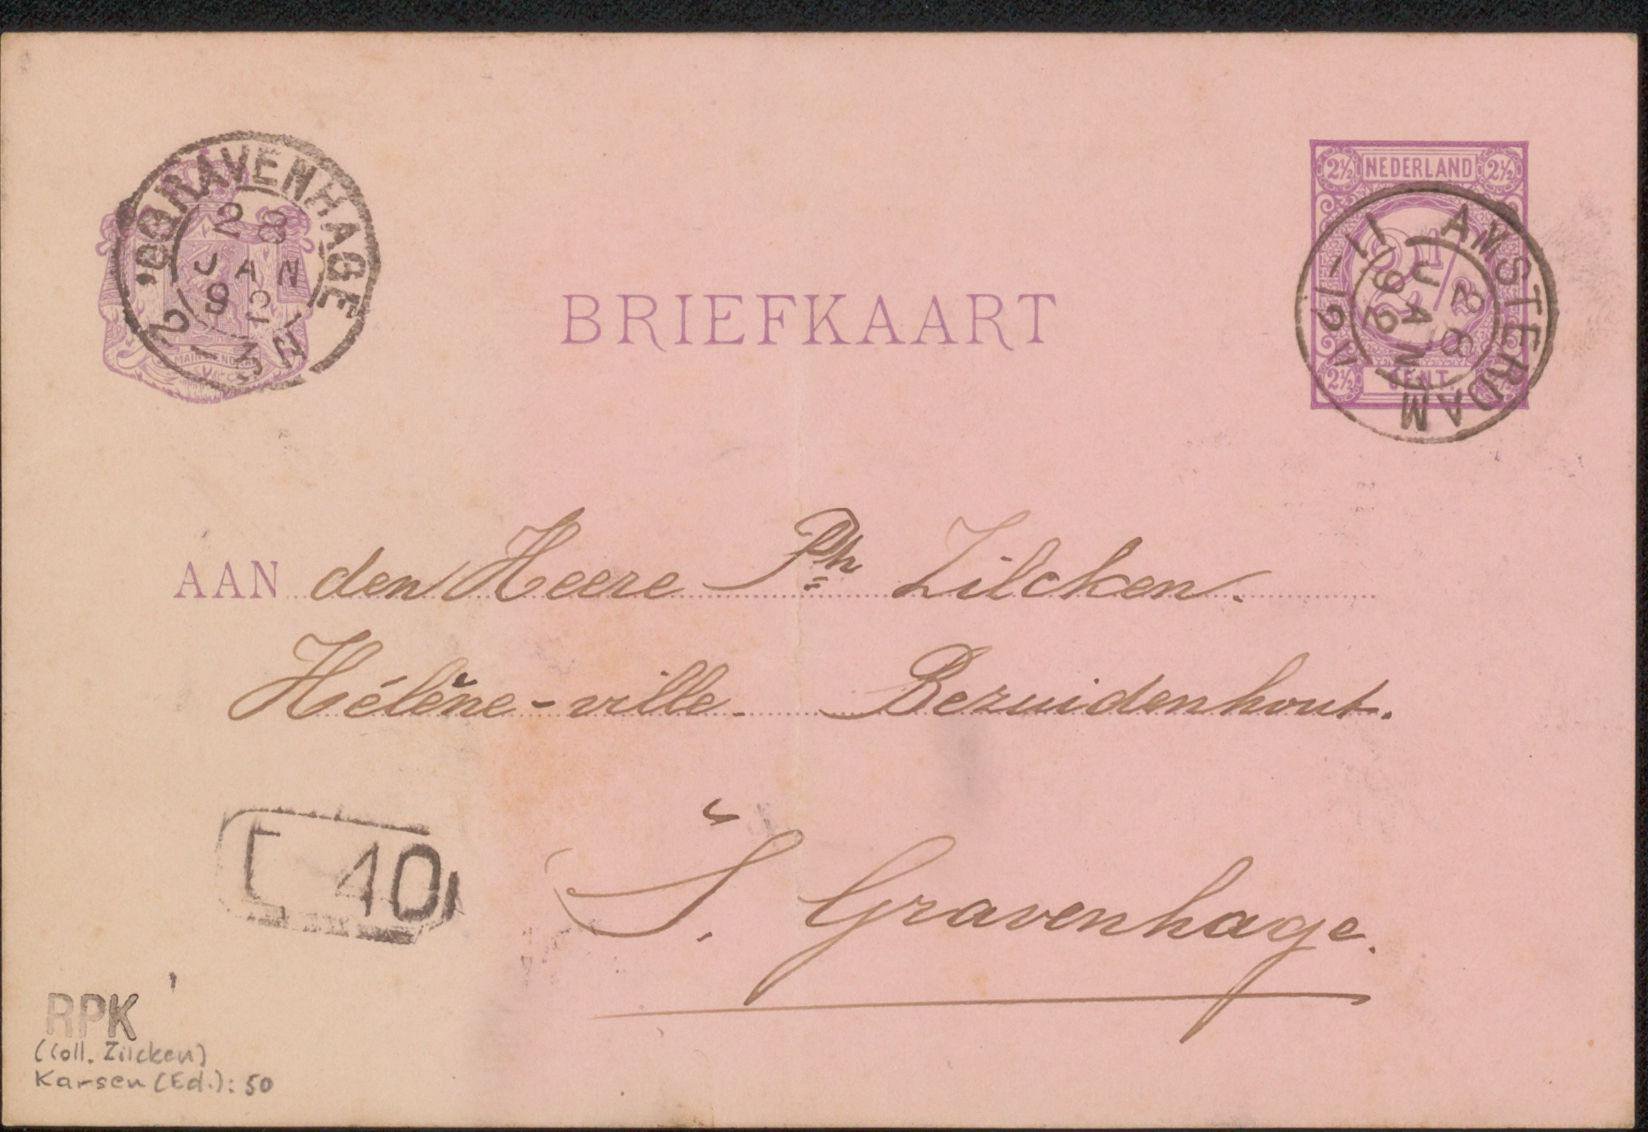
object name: postcard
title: Briefkaart aan Philip Zilcken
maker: eduard karsen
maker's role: draughtsman, painter, print maker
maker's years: 1860-1941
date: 1892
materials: cardboard, ink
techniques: pen, writing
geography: amsterdam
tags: martinus mouton, the hague, philip zilcken, money, amsterdam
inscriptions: collector's mark: ‘RPK’